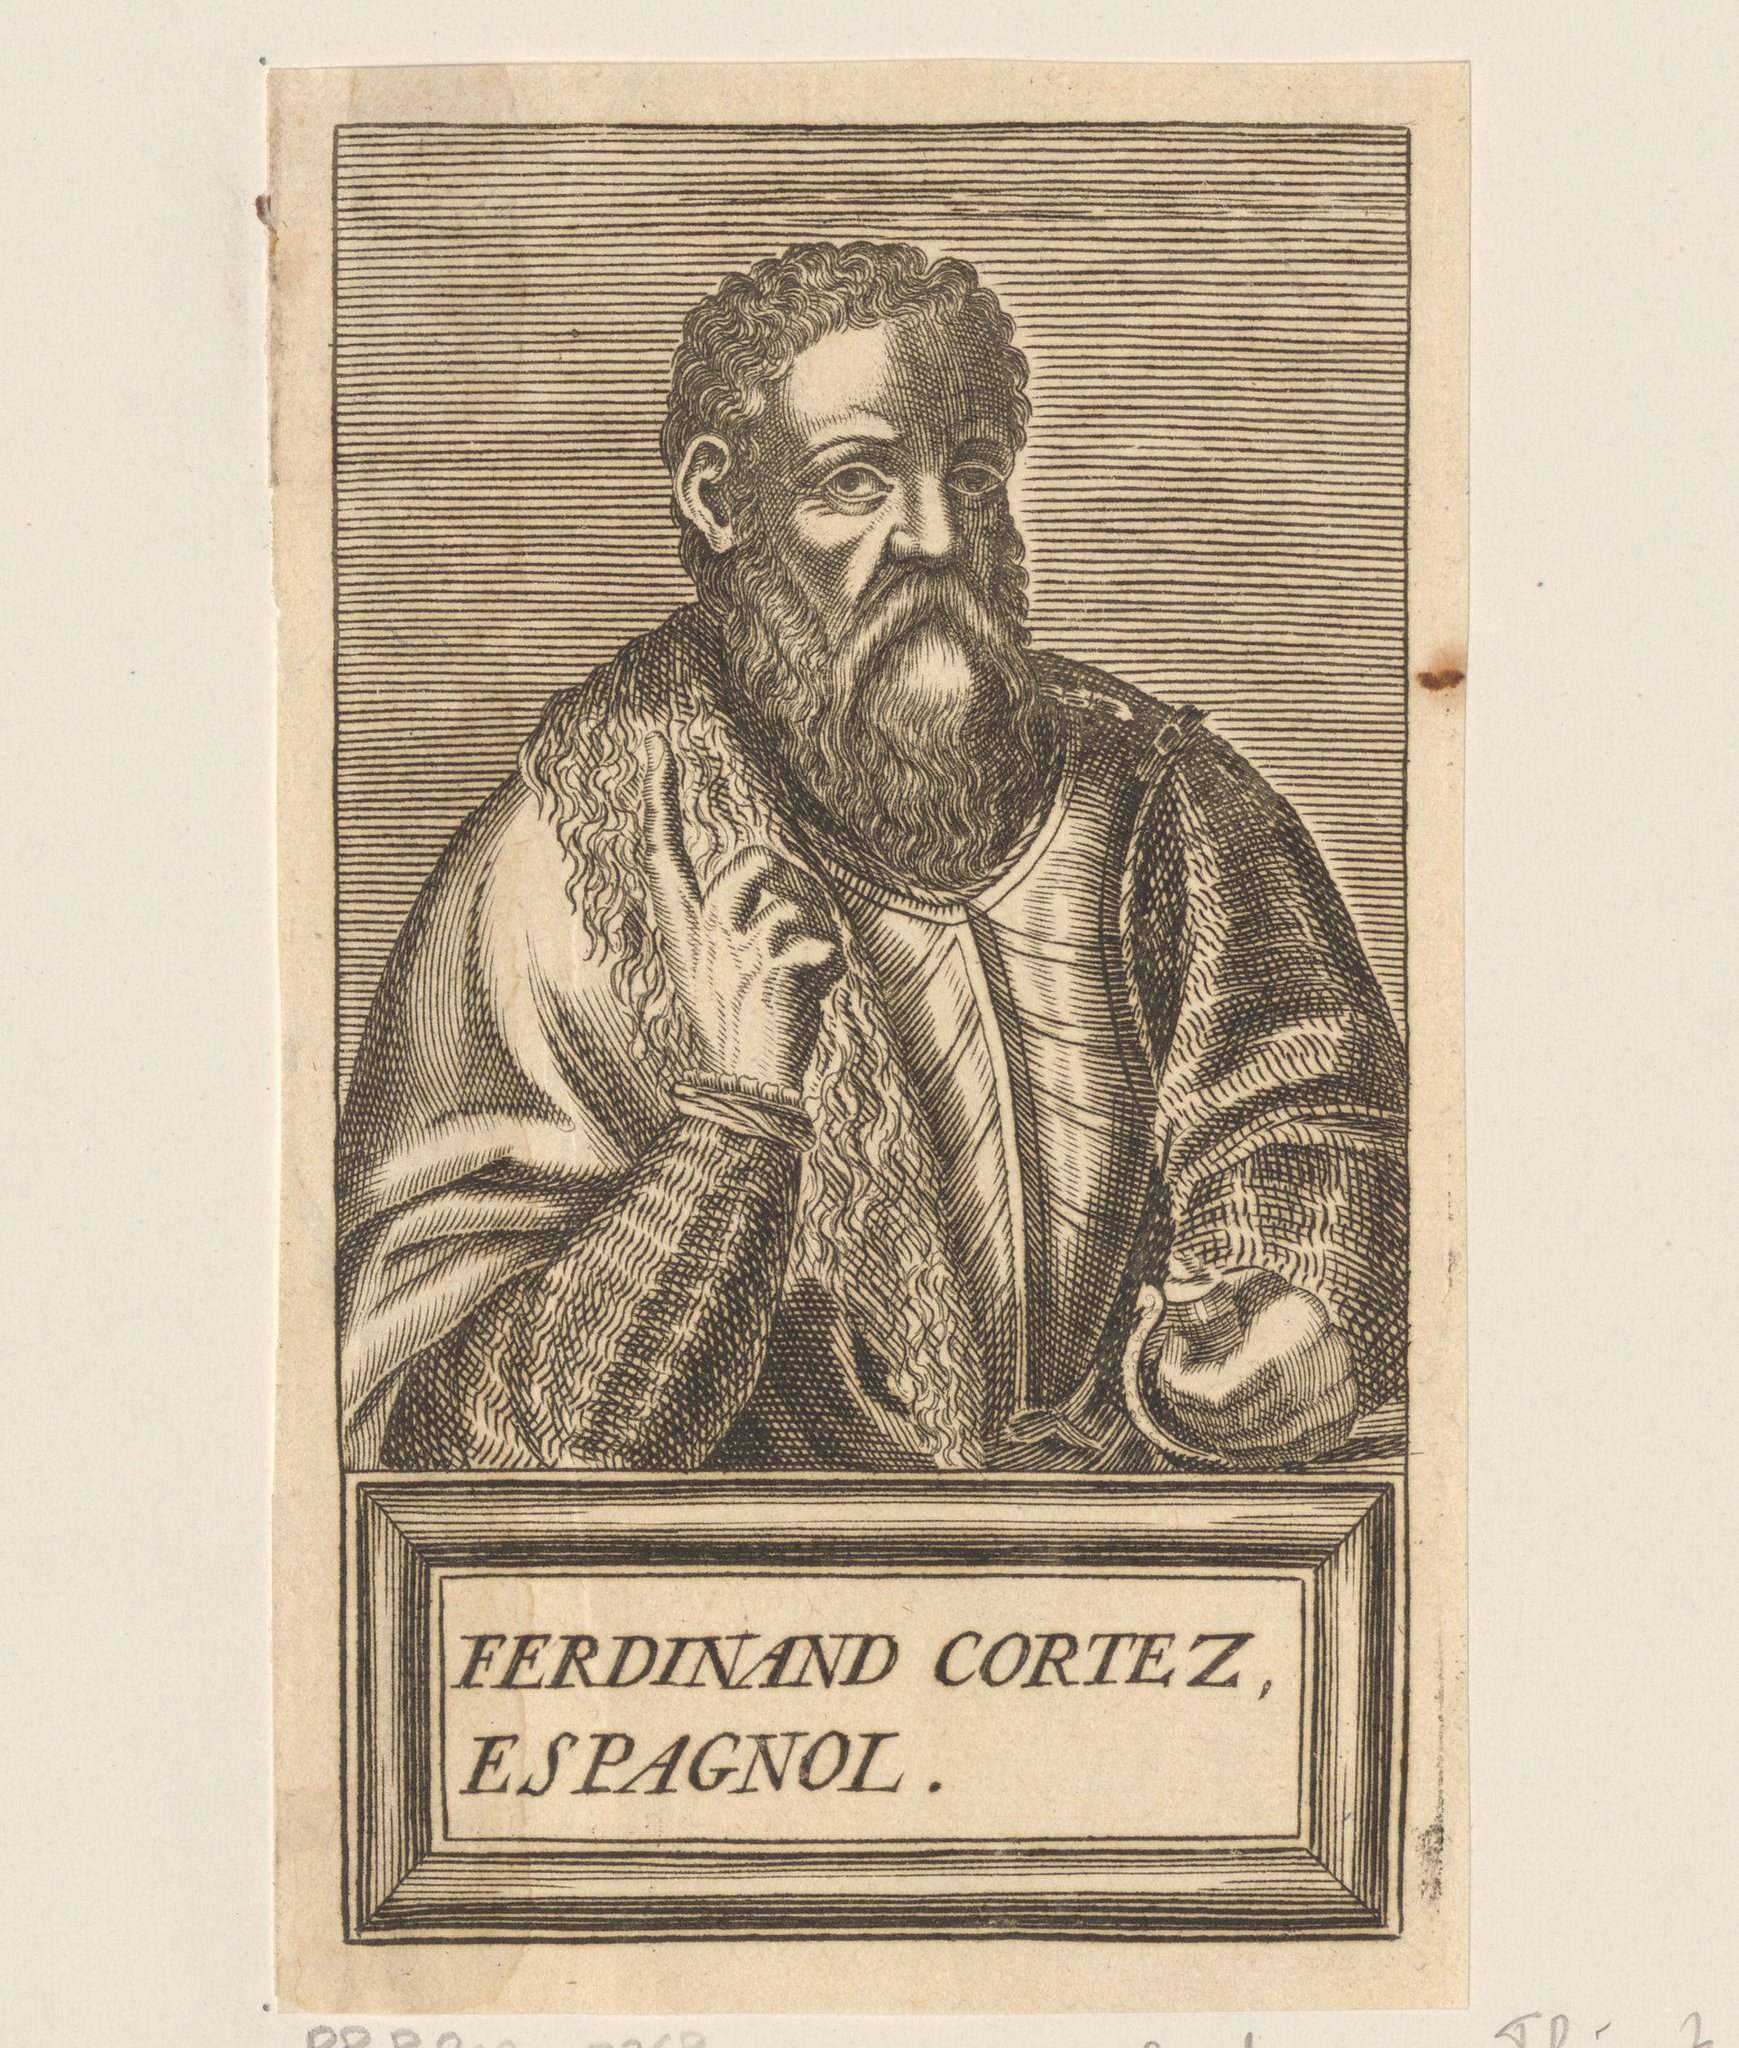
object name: print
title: Portret van Hernán Cortés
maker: Anonymous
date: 1600-1699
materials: paper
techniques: engraving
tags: historical persons